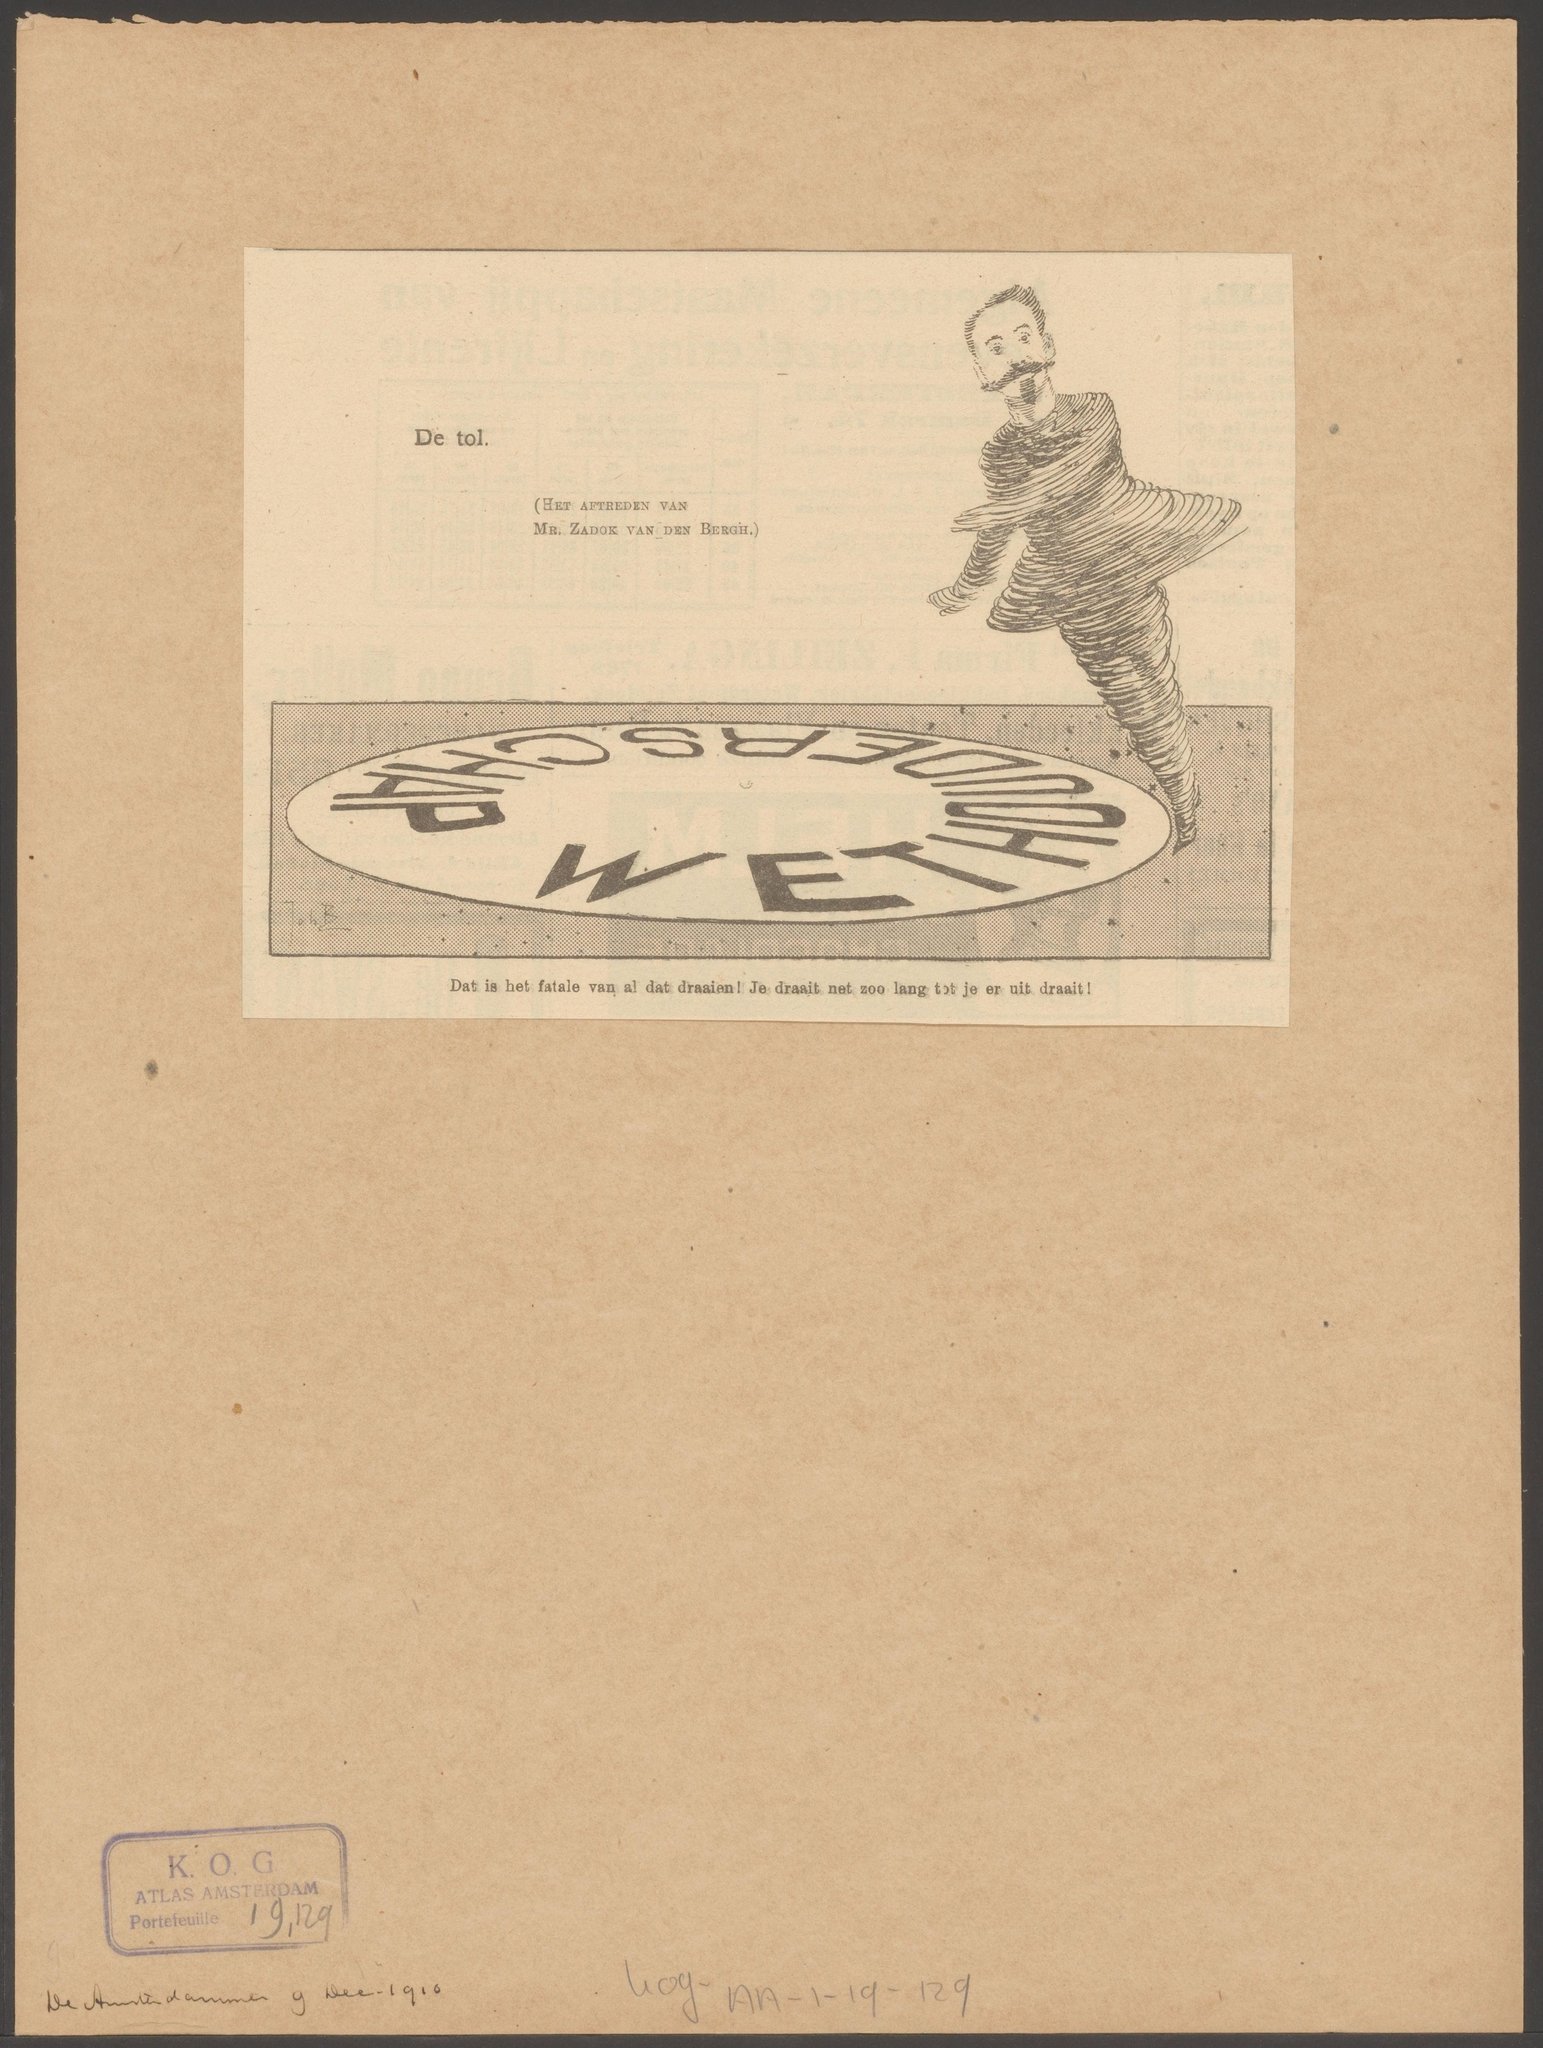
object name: cartoon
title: Spotprent op het aftreden van Zadok van den Bergh als wethouder van Amsterdam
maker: johan braakensiek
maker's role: draughtsman, print maker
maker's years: 1858-1940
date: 1910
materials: paper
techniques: letterpress printing, line block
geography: amsterdam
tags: oss, politician, e.g. party leader, political caricatures and satires, amsterdam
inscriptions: collector's mark: ‘19,129’ Lugt 1641b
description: Onderwerpsrubriek binnen de Atlas Amsterdam: Herinneringen aan regeringsleden en hunne huisgezinnen [na 1800].